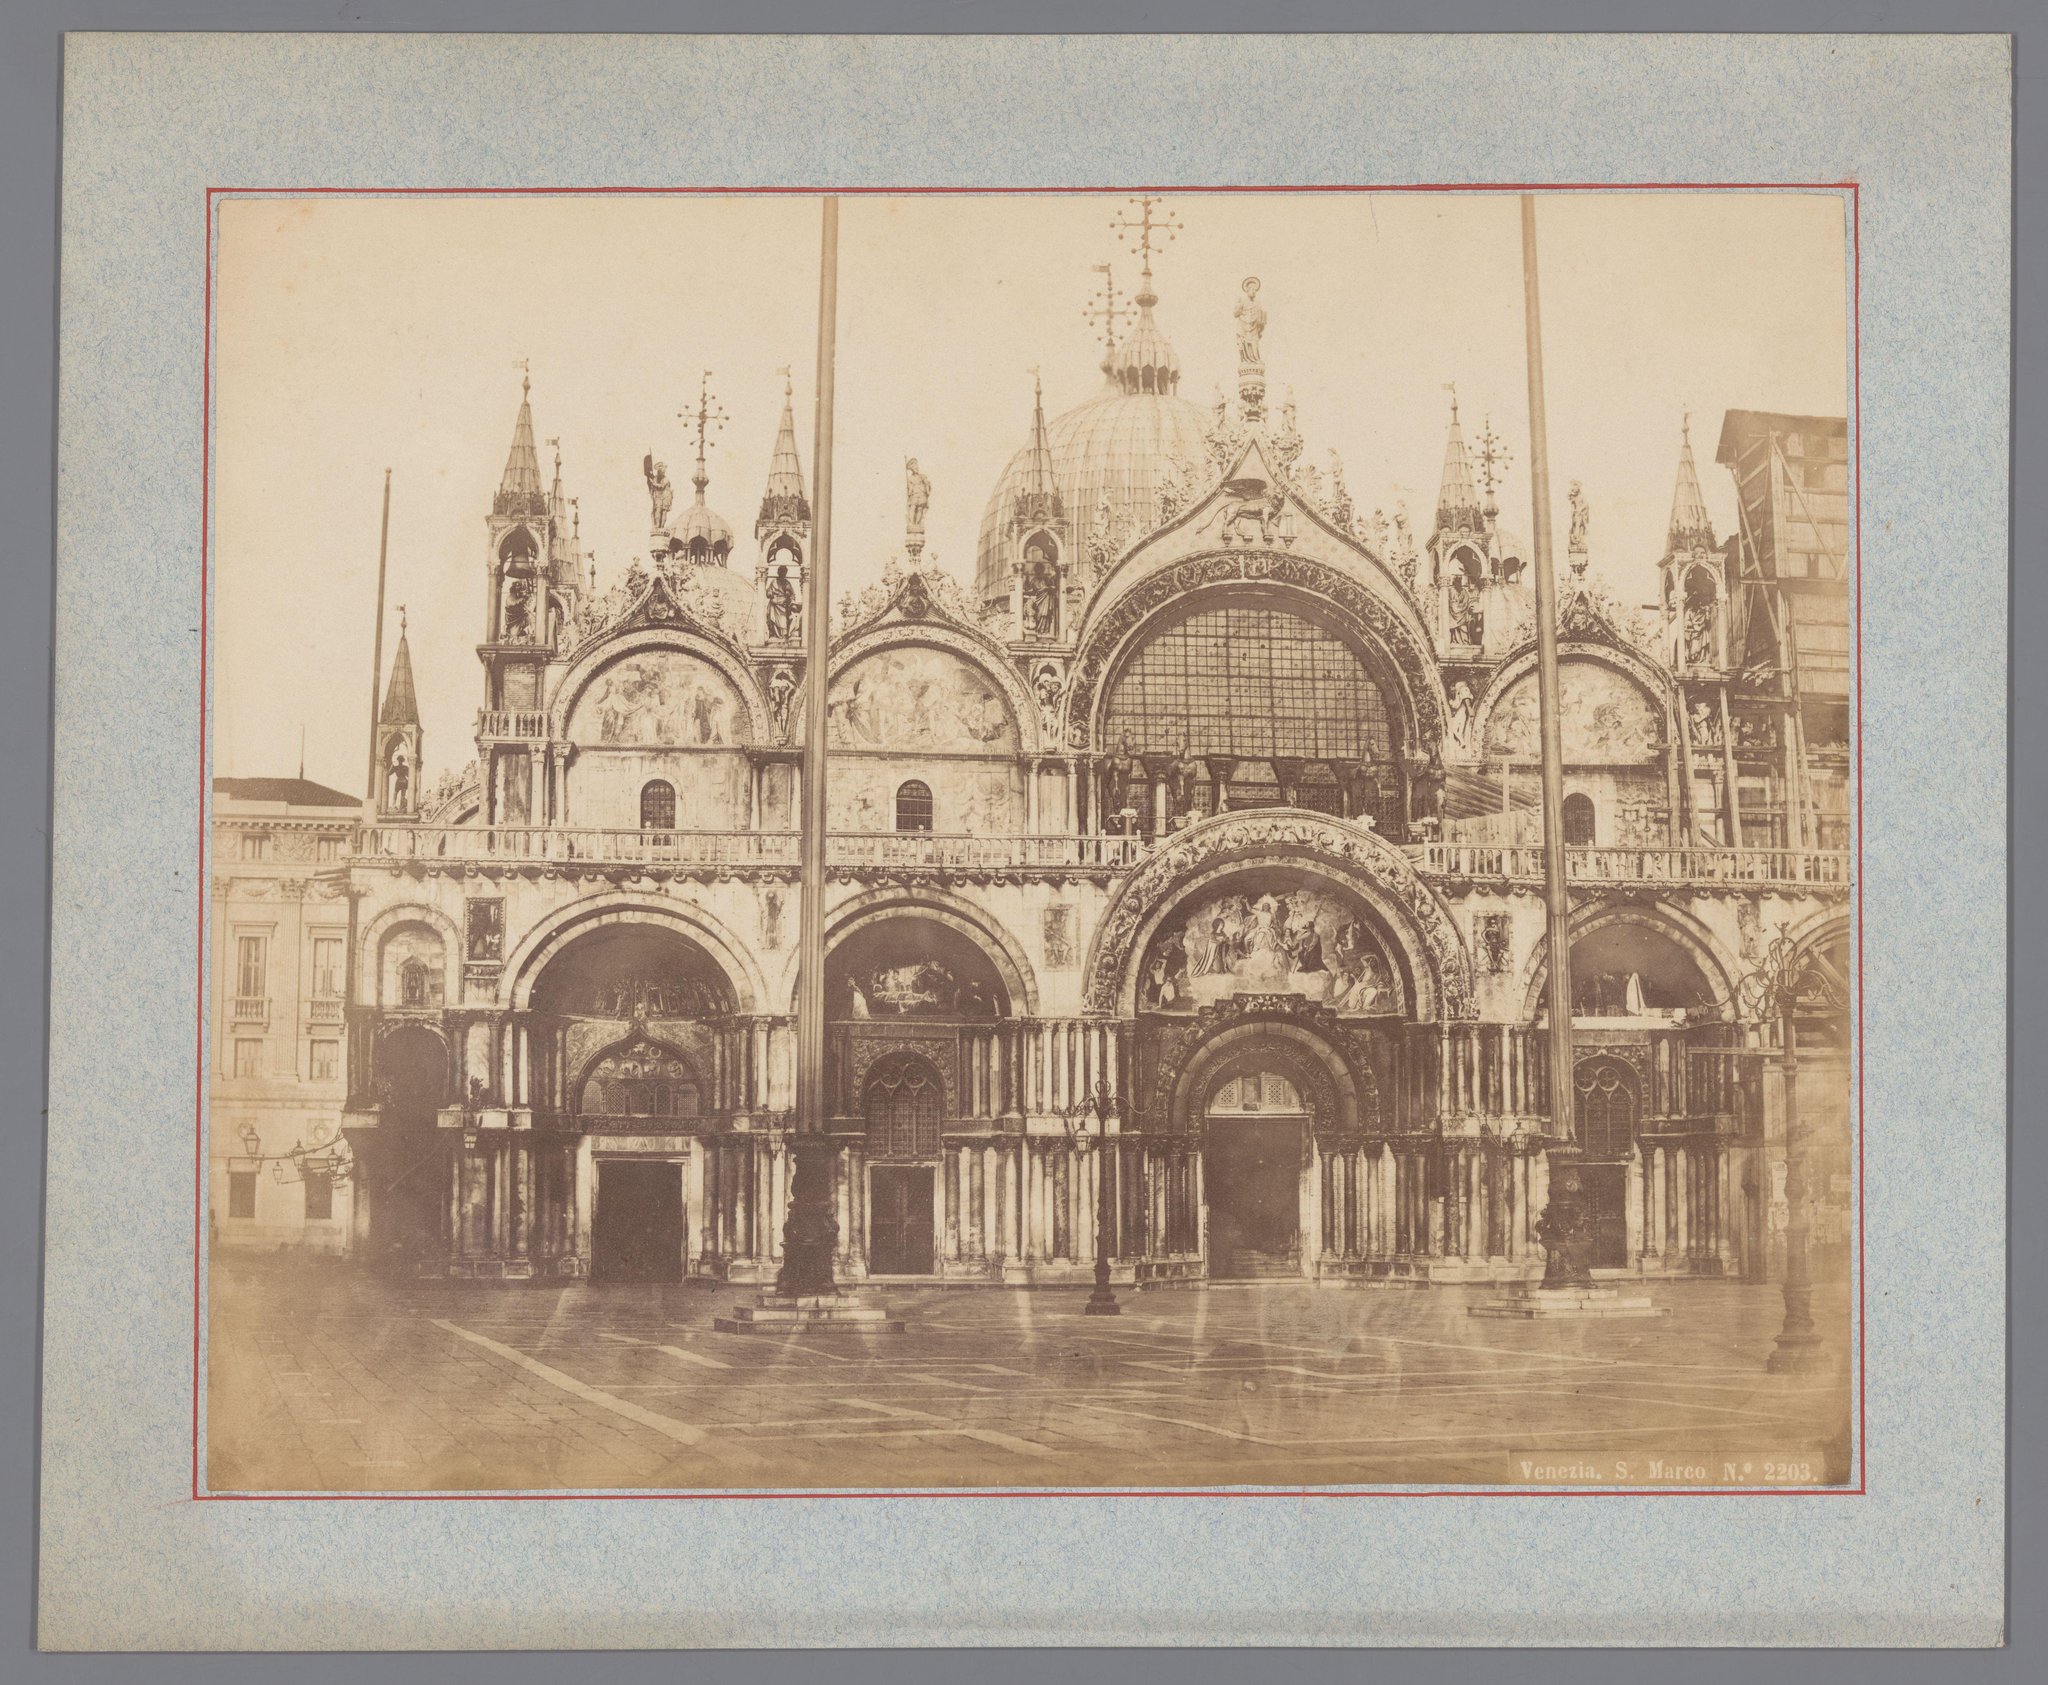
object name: photograph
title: Westgevel van de San Marco te Venetië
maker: Anonymous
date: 1851-1900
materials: cardboard, paper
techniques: albumen print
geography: venice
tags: parts of church exterior and annexes: west façade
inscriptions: number: ‘No. 2203.’